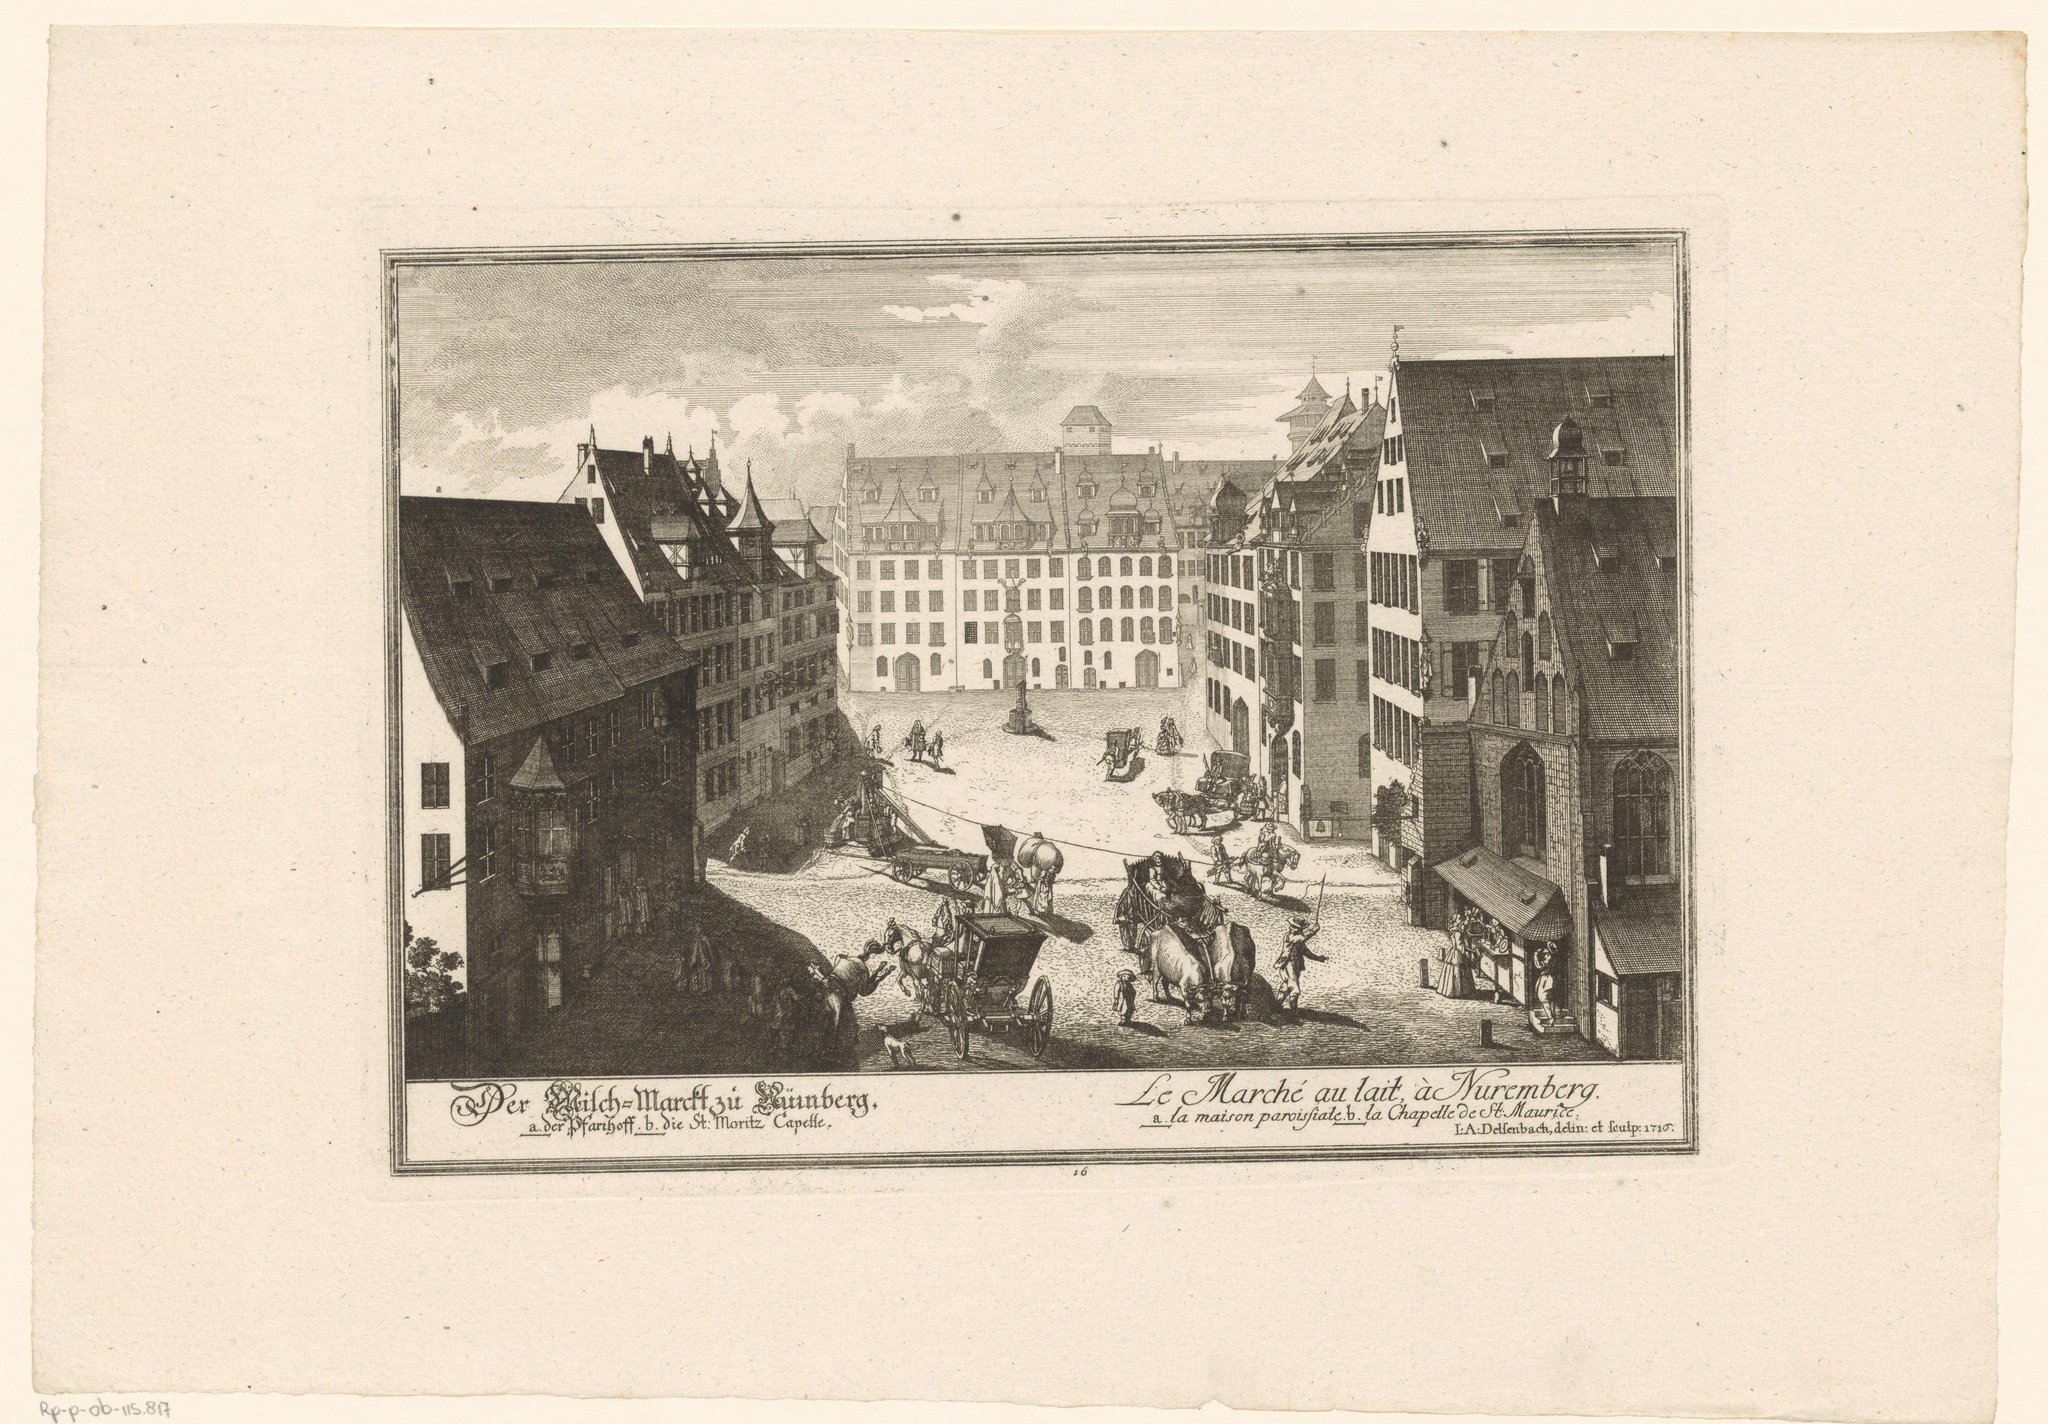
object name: print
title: Gezicht op de Melkmarkt in Neurenberg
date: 1716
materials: paper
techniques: etching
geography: nuremberg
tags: city-view in general; 'veduta', market, milk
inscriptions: collector's mark: Lugt 2228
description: Deze prent behoort tot een serie van Neurenbergse stadsgezichten gemaakt door Johann Adam Delsenbach. Het Rijksmuseum heeft zestien prenten uit deze reeks in bezit, waarvan de laatste is voorzien van nummer 24. Het is onduidelijk uit hoeveel prenten de originele serie bestaat.